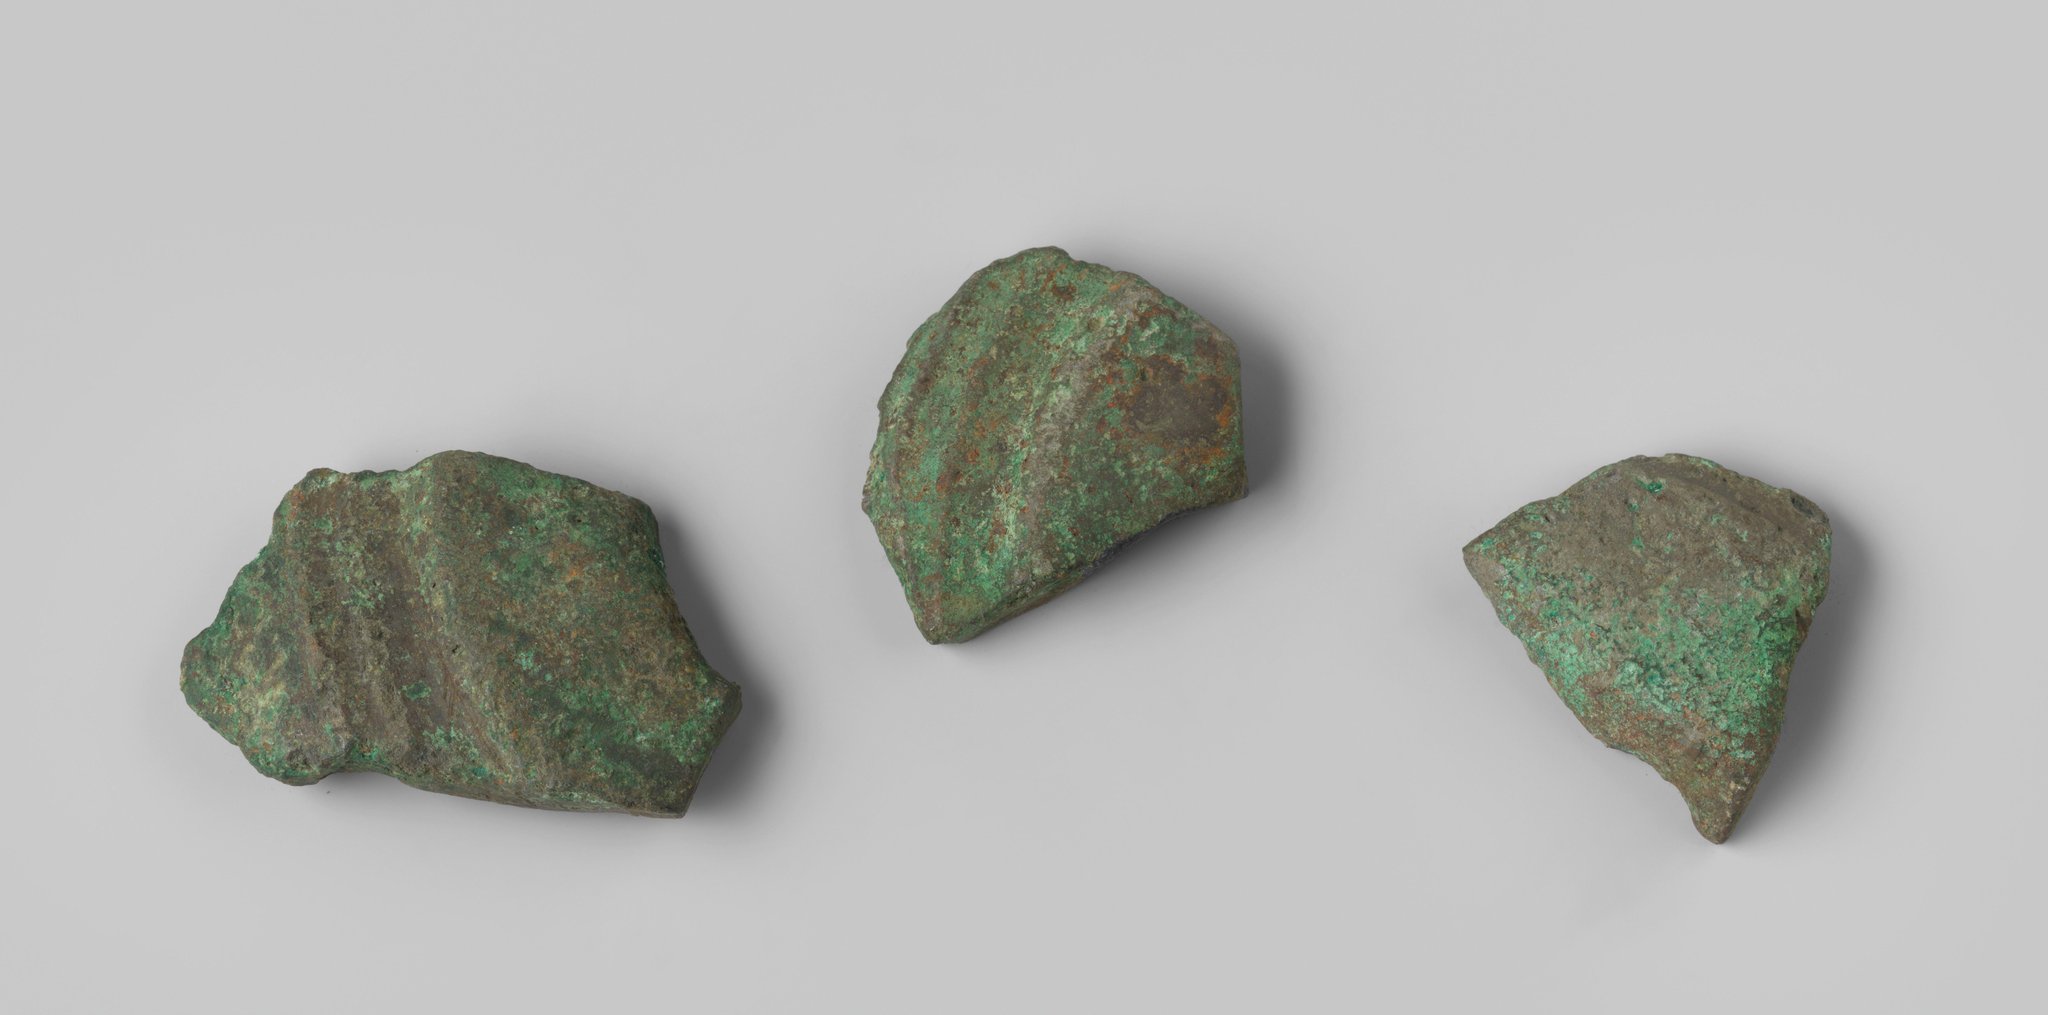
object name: ship bell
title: Fragmenten scheepsbel uit het wrak van de Oost-Indiëvaarder Hollandia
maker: Anonymous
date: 1700-1743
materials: copper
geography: netherlands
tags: verenigde oostindische compagnie, hollandia (schip), annet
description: Acoustic, bell (ship's); fragment of shoulder, eroded, traces of relieved moulding.